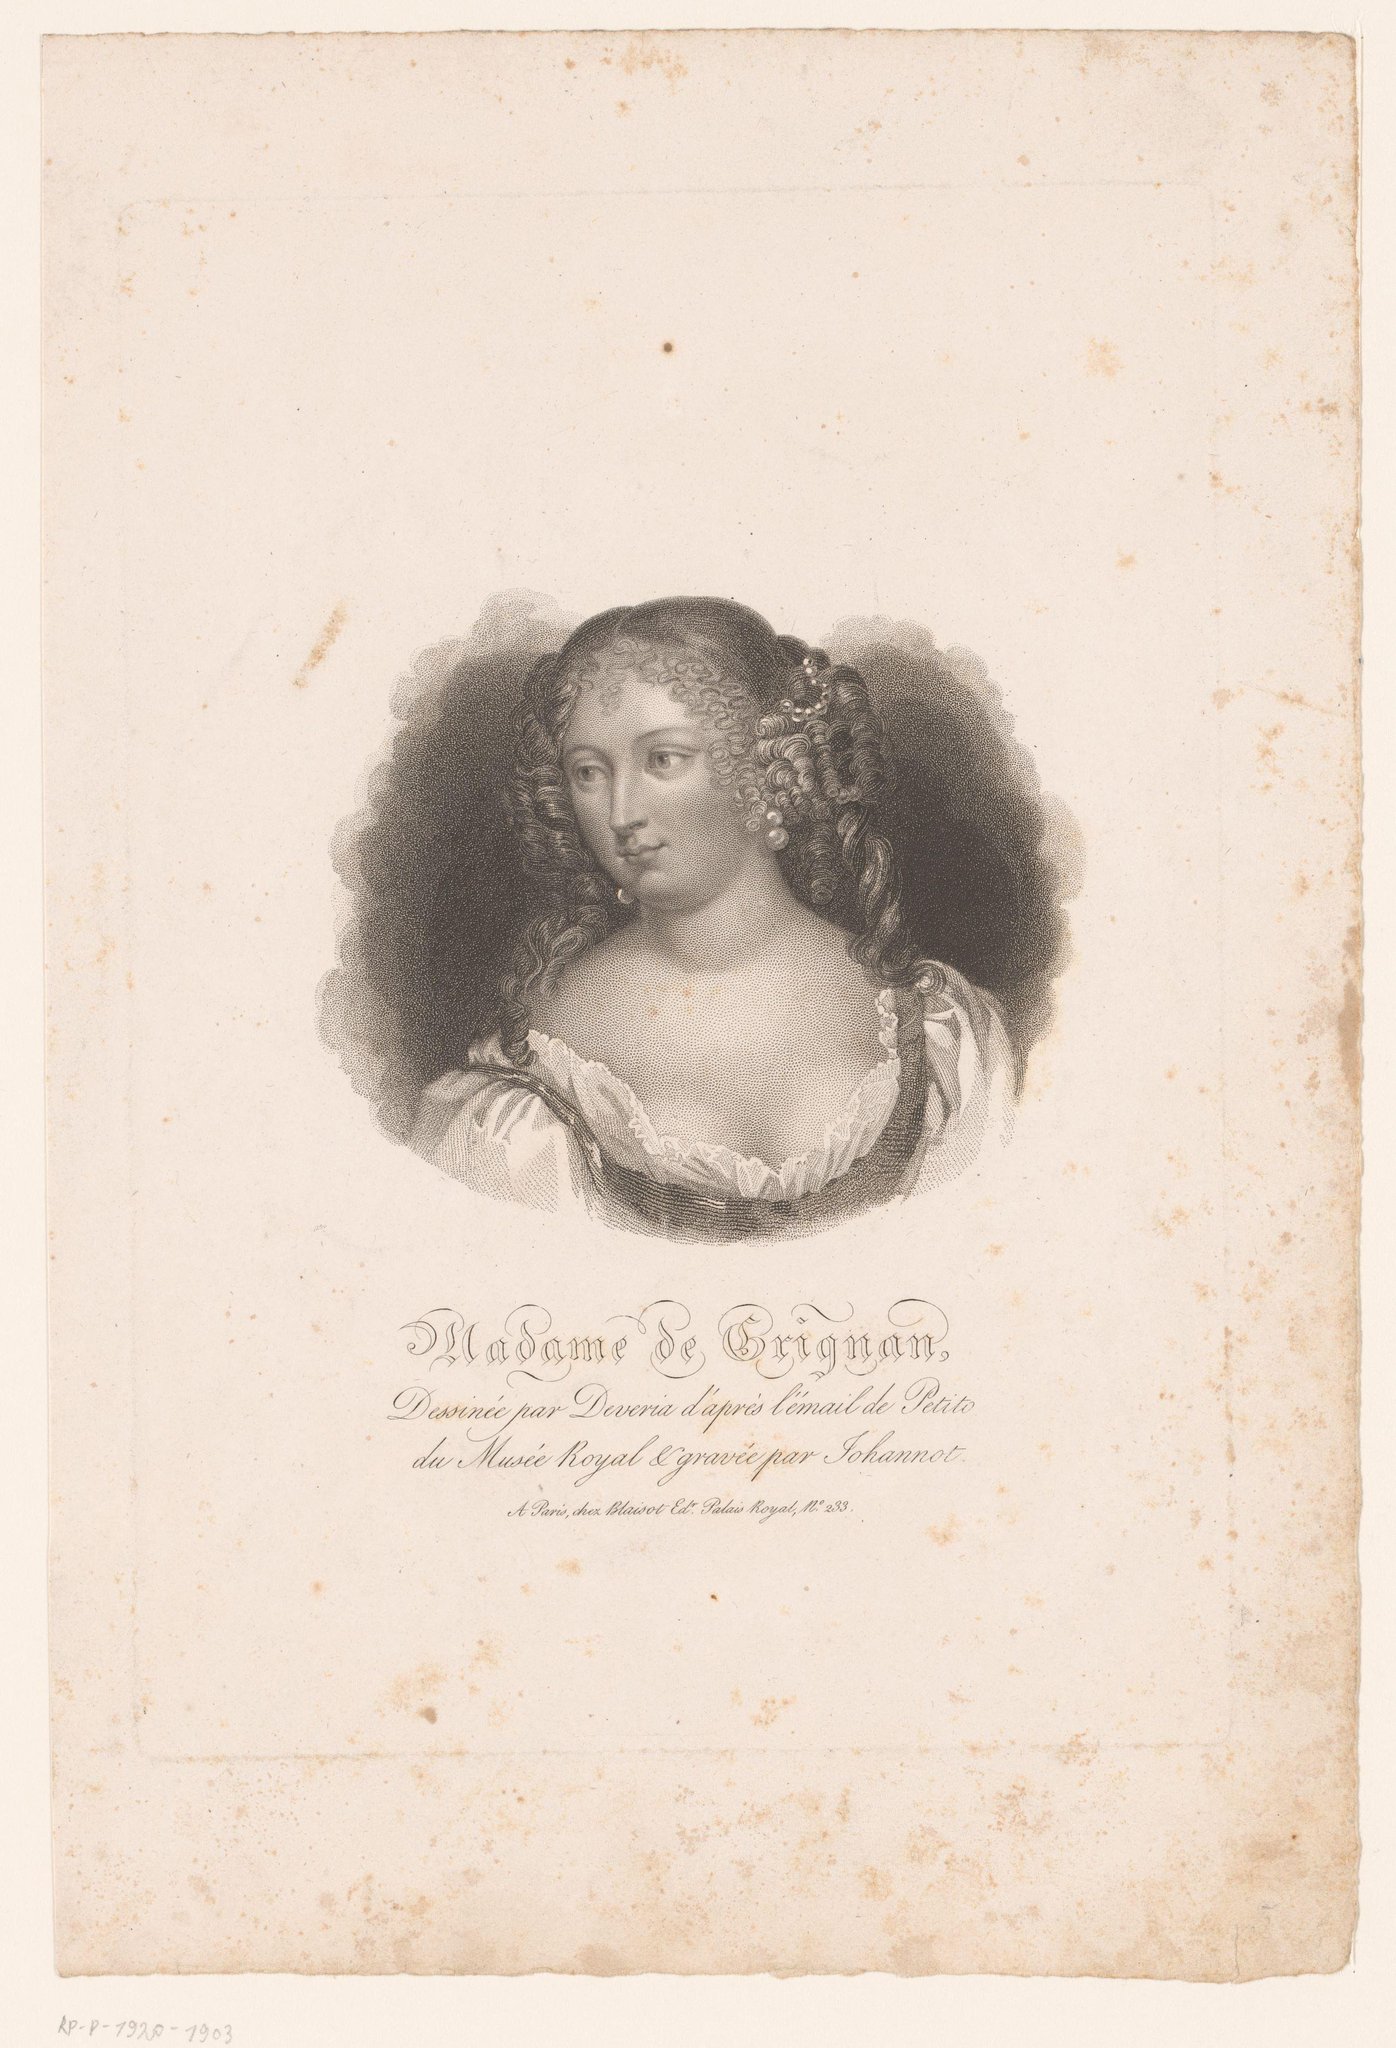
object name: print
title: Madame de Grignan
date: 1829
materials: paper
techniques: engraving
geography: france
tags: paris, marseille, historical persons - bb - woman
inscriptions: collector's mark: Lugt 2228